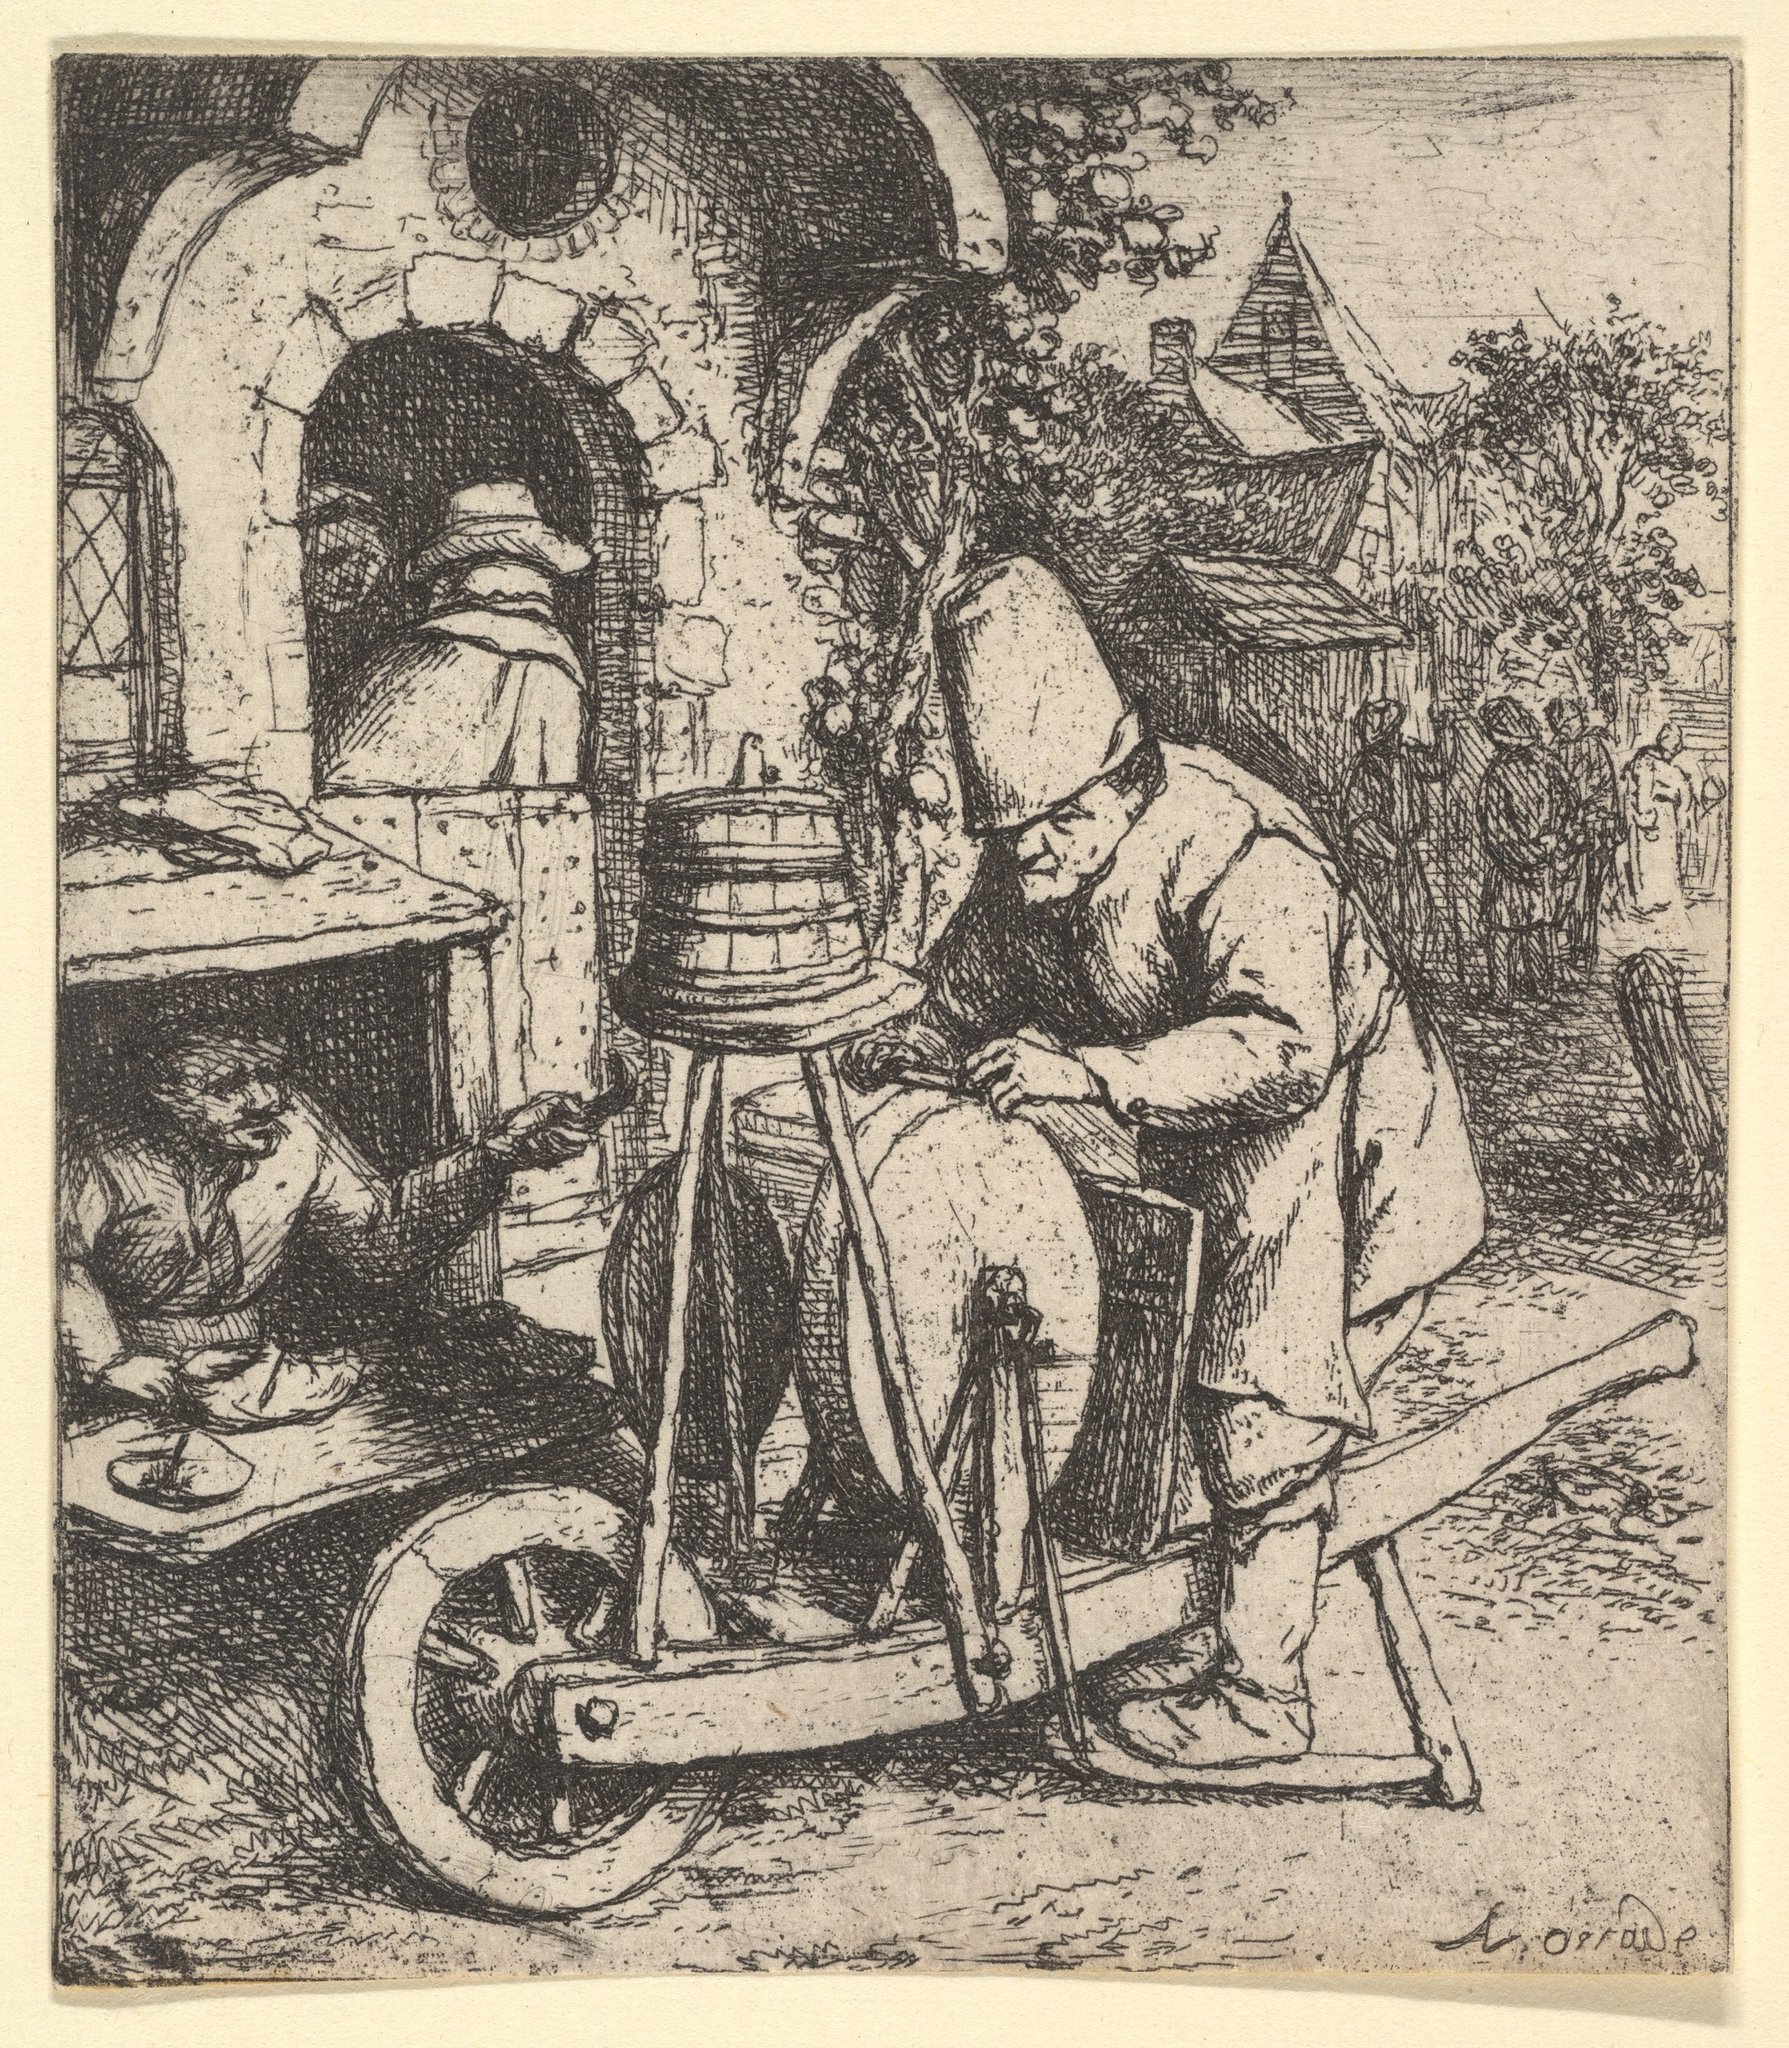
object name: print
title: The Knifegrinder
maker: adriaen van ostade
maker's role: artist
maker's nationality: dutch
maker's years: 1610-1685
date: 1610-1685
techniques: etching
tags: buildings,men,working